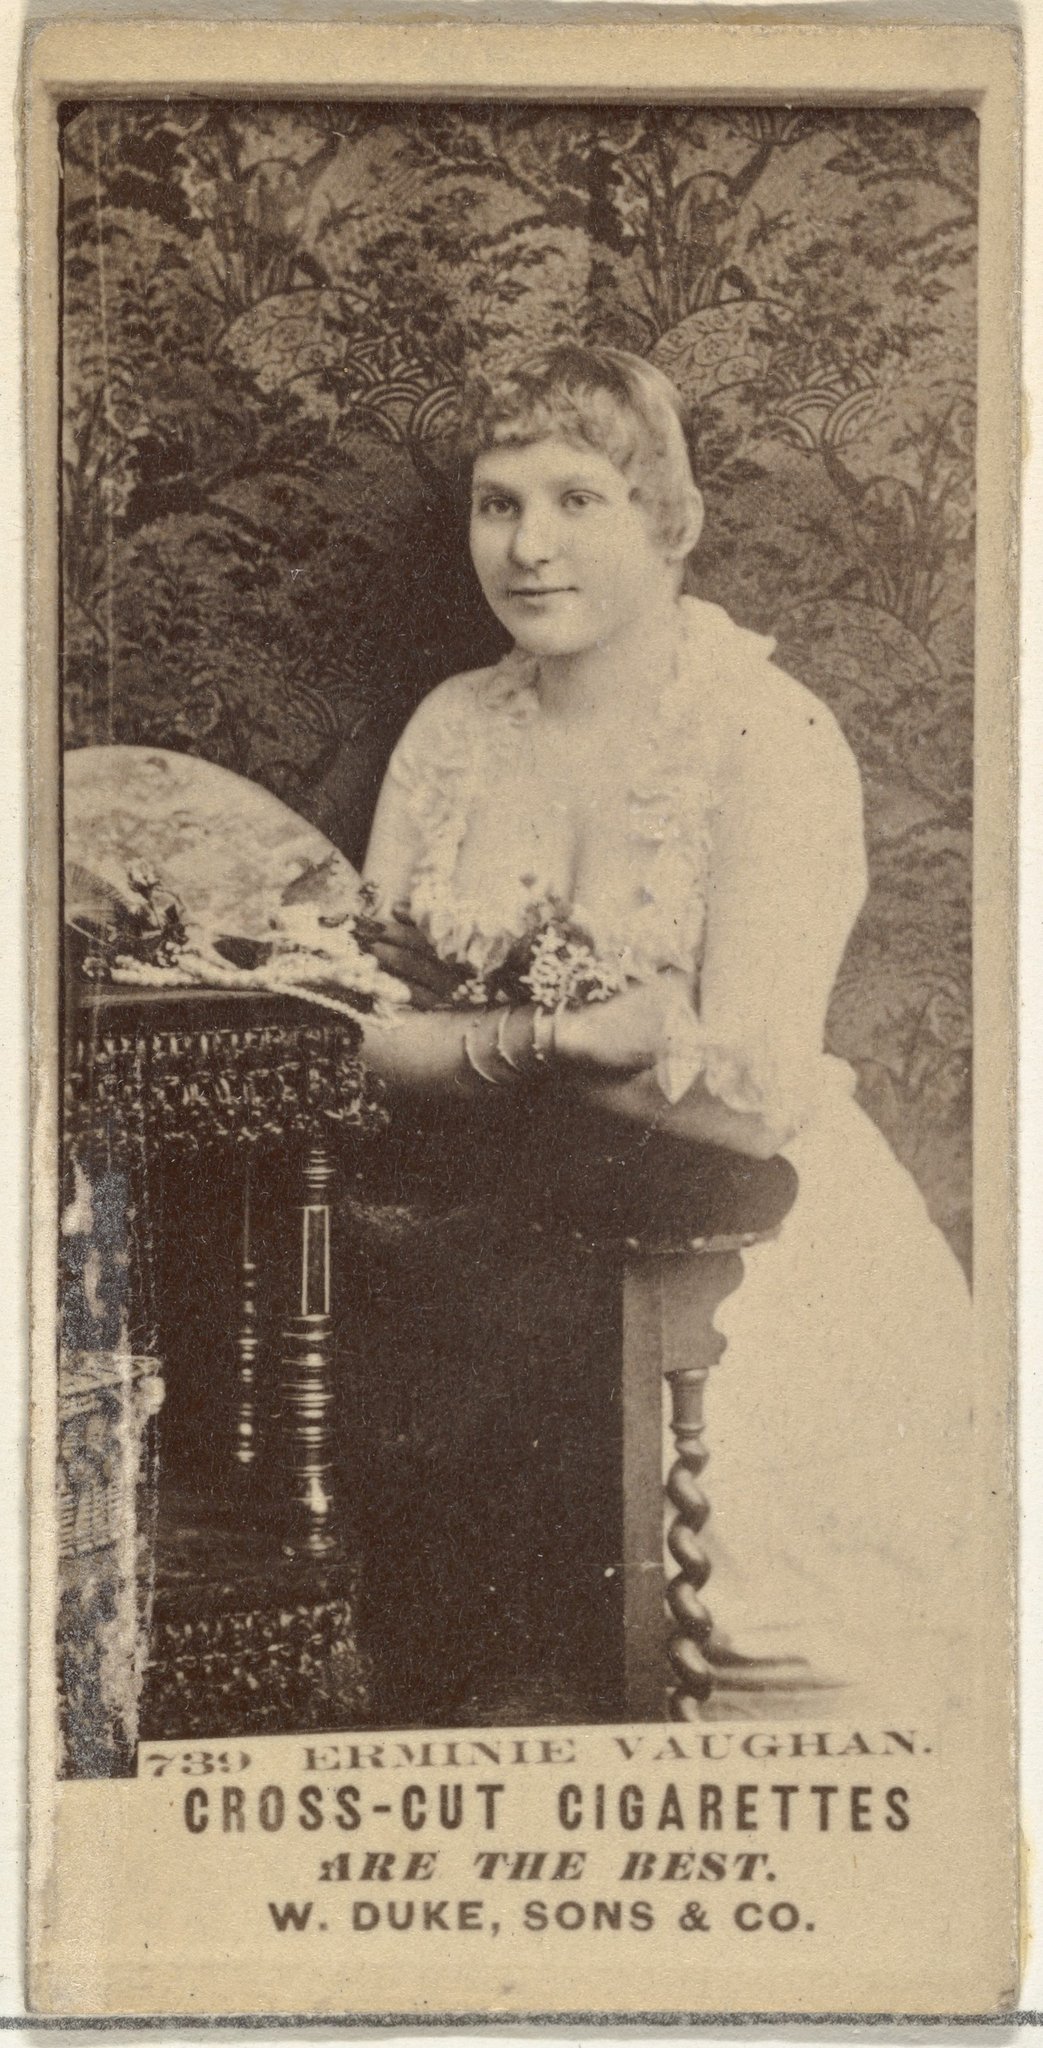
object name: photograph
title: Card Number 739, Erminie Vaughan, from the Actors and Actresses series (N145-3) issued by Duke Sons & Co. to promote Cross Cut Cigarettes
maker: w. duke, sons & co.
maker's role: publisher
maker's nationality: american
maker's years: 1870-1920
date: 1880-1889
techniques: albumen silver print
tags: portraits,women,actresses